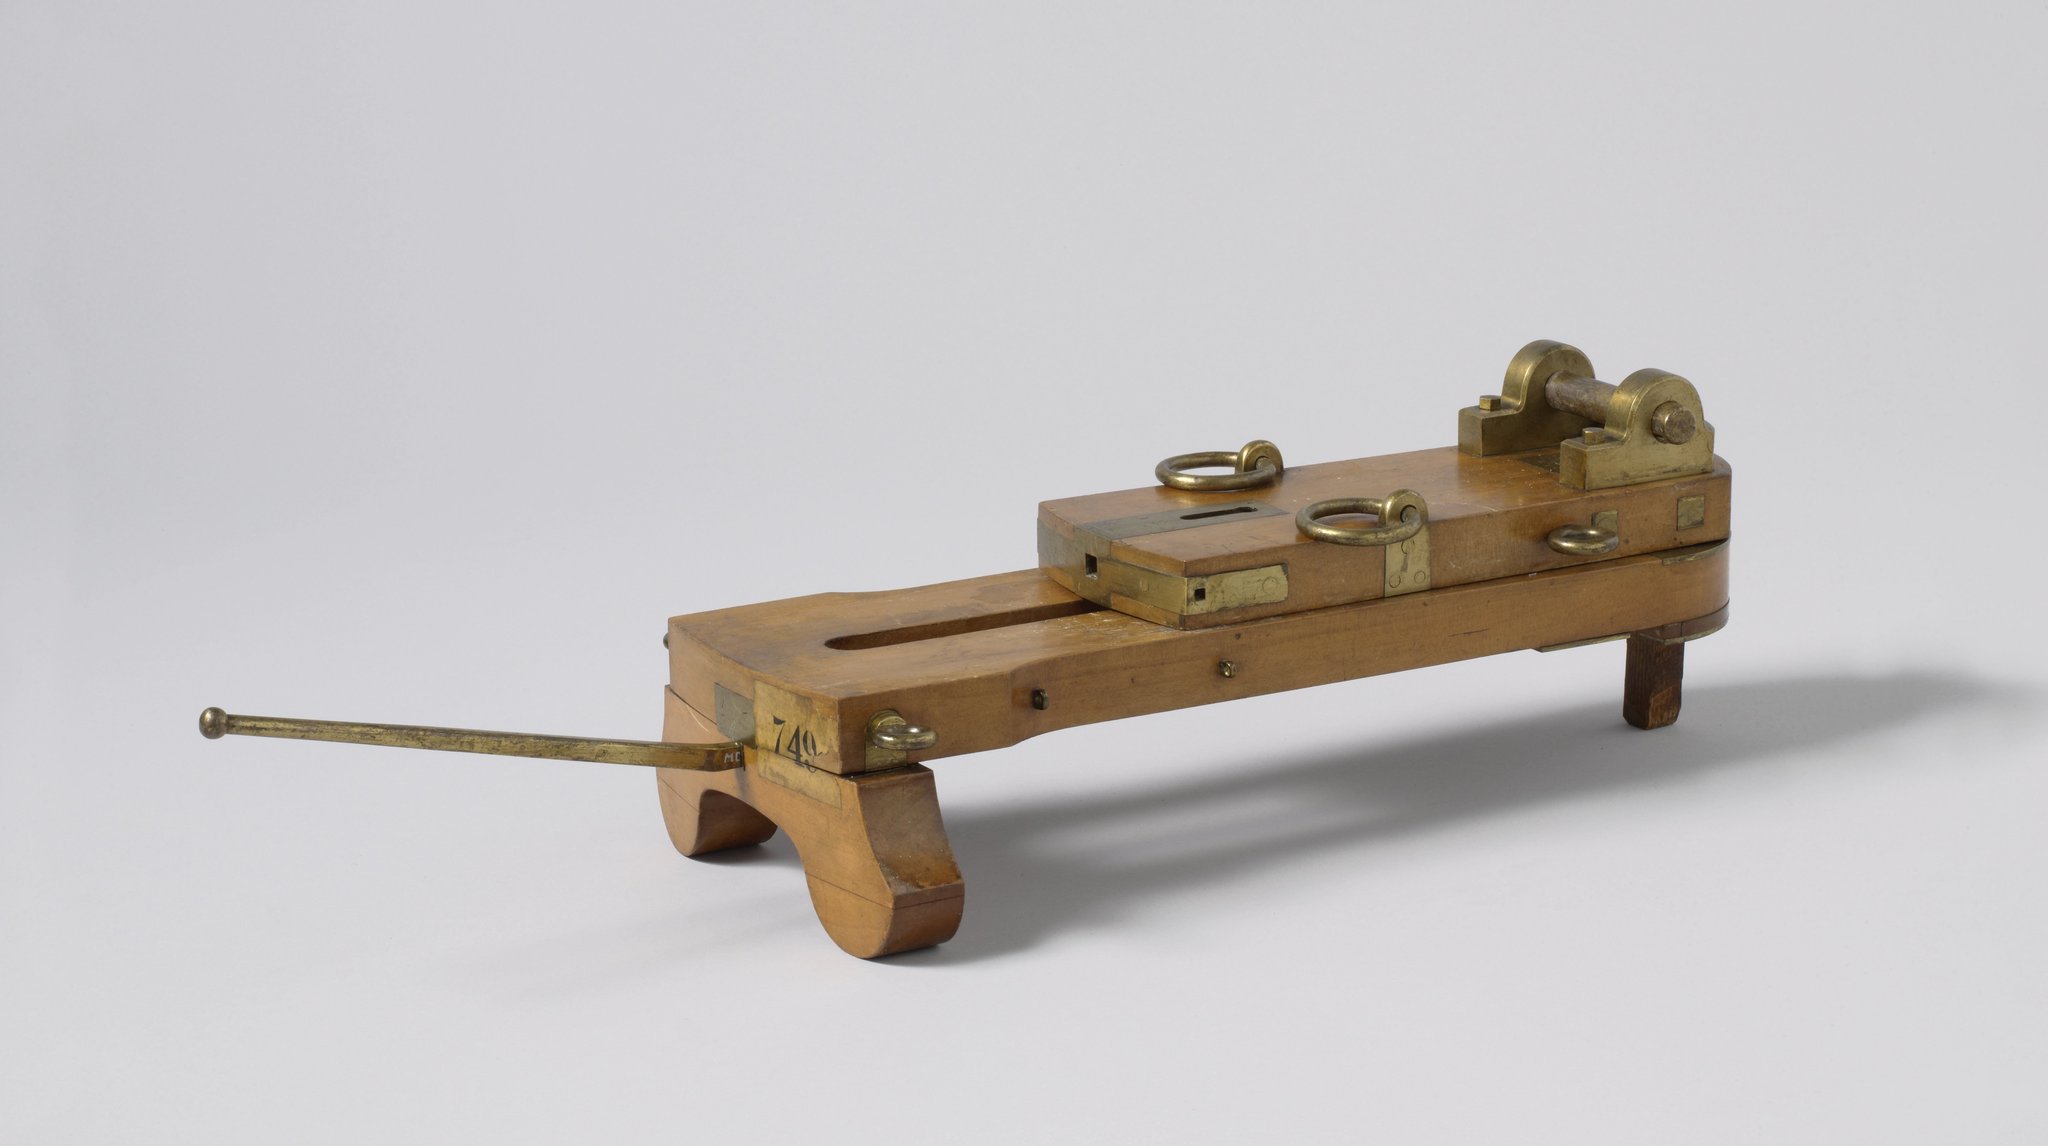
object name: demonstration model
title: Model of a Slide and Carriage for a 30-Pounder Carronade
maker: Anonymous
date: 1848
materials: brass, wood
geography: netherlands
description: Model van een boven- en onderslede voor een carronade van 30 pond. met baksijzer, incompleet. De bovenslede heeft een licht trapezevormig lichaam met messing beslag en ringen, de voor- en achterkant zijn afgerond. Tegen de achterkant de bakskoker in messing beslag en bovenop het spoor voor de eleveerschroef, aan de voorkant de oren met tapas en de wervelbout aan de onderkant. Met een platte rechthoekige kop loopt de wervelbout door de gleuf van de onderslede. De onderslede is een houten raam, aan de voorkant afgerond, gedeeltelijk met messing beslagen en voorzien van een gat voor de spilbout; iets naar achteren is aan de onderzijde een borgplaat met twee gaten aangebracht, waarmee de slede in de lengterichting tegen de scheepsboord werd geborgd. Aan de achterkant verbreedt de onderslede en is een weinig afgerond. De slede wordt hier ondersteund door een klos met twee poten, aan de onderzijde afgerond zodat er zo weining mogelijk wrijving is bij het baksen. Het kogelraam, dat onder de onderslede wordt gehangen, ontbreekt. Schaal 1:5 (afgeleid).